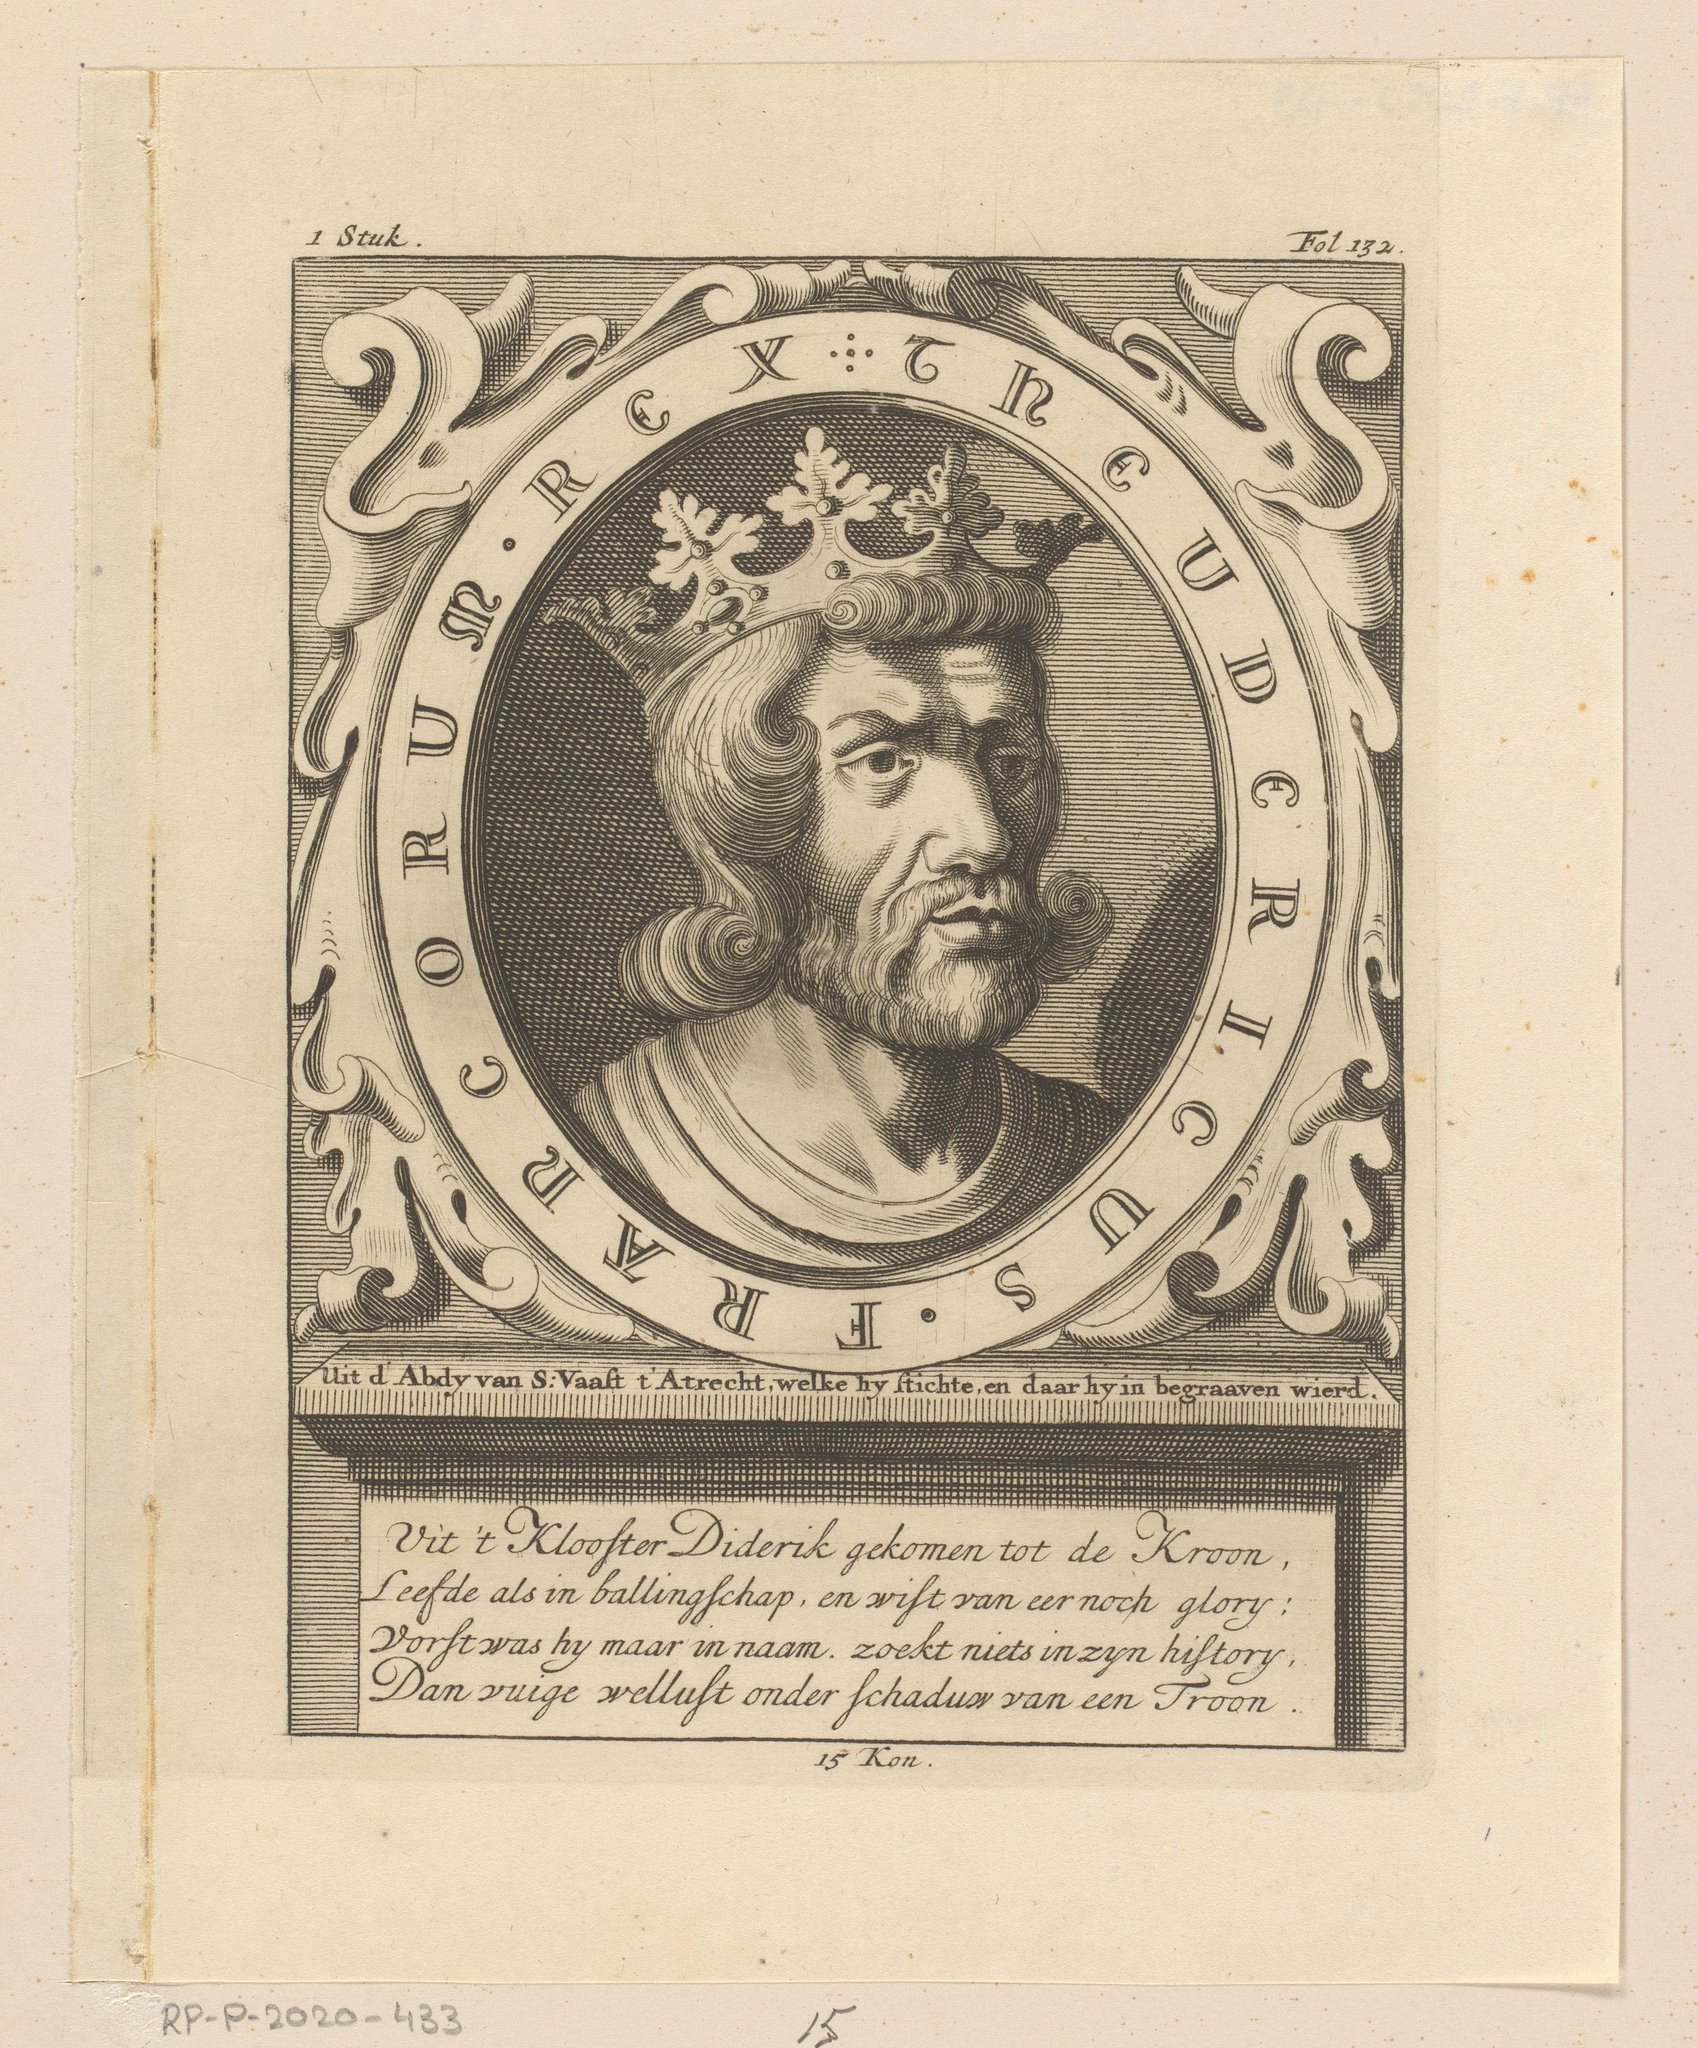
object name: print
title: Theudericus Francorum rex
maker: Anonymous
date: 1685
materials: paper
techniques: engraving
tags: historical persons, ruler, sovereign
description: Prent ook gebruikt in: Eudes de Mézeray, François. Chronyk van Vrankryk. 6 dln. Amsterdam: Jan Bouman en Timotheum ten Hoorn, 1685, dl. 1.